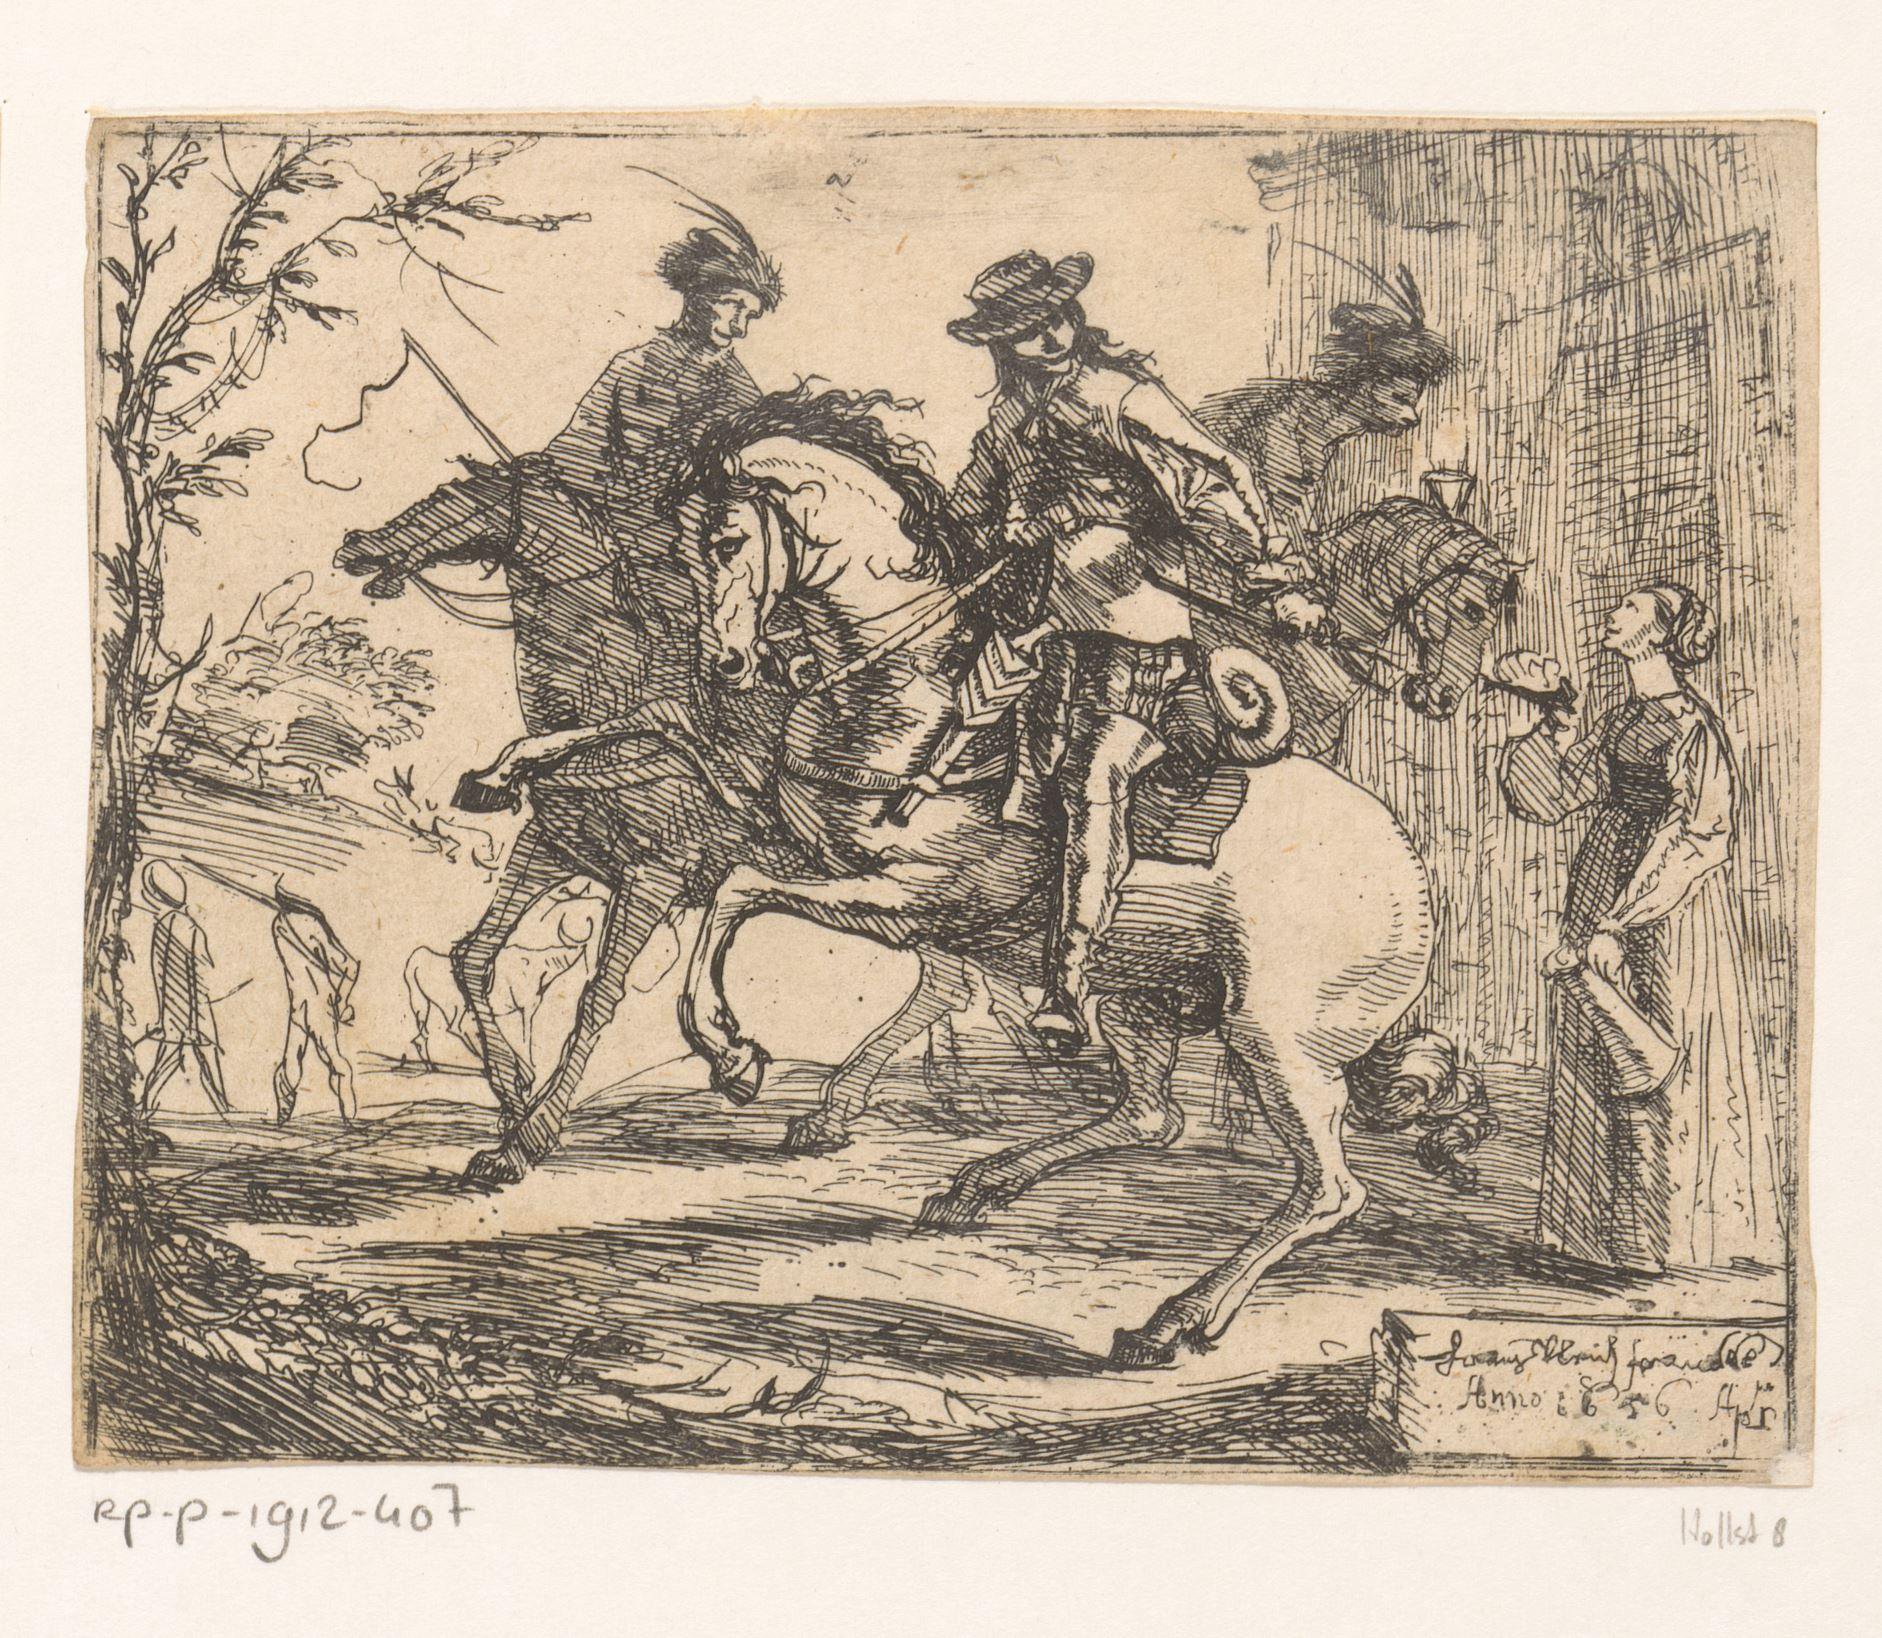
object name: print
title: Drie ruiters voor een herberg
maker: hans ulrich franck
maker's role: draughtsman, print maker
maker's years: 1603-1680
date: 1604-1656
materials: paper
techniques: etching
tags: riding a horse, ass, or mule; rider, horseman, giving drink, hotel, hostelry, inn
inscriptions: collector's mark: Lugt 2241, collector's mark: Lugt 2228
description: Prent uit een serie van vijfentwintig militaire voorstellingen, waarvan tien in de collectie van het RMA aanwezig zijn.